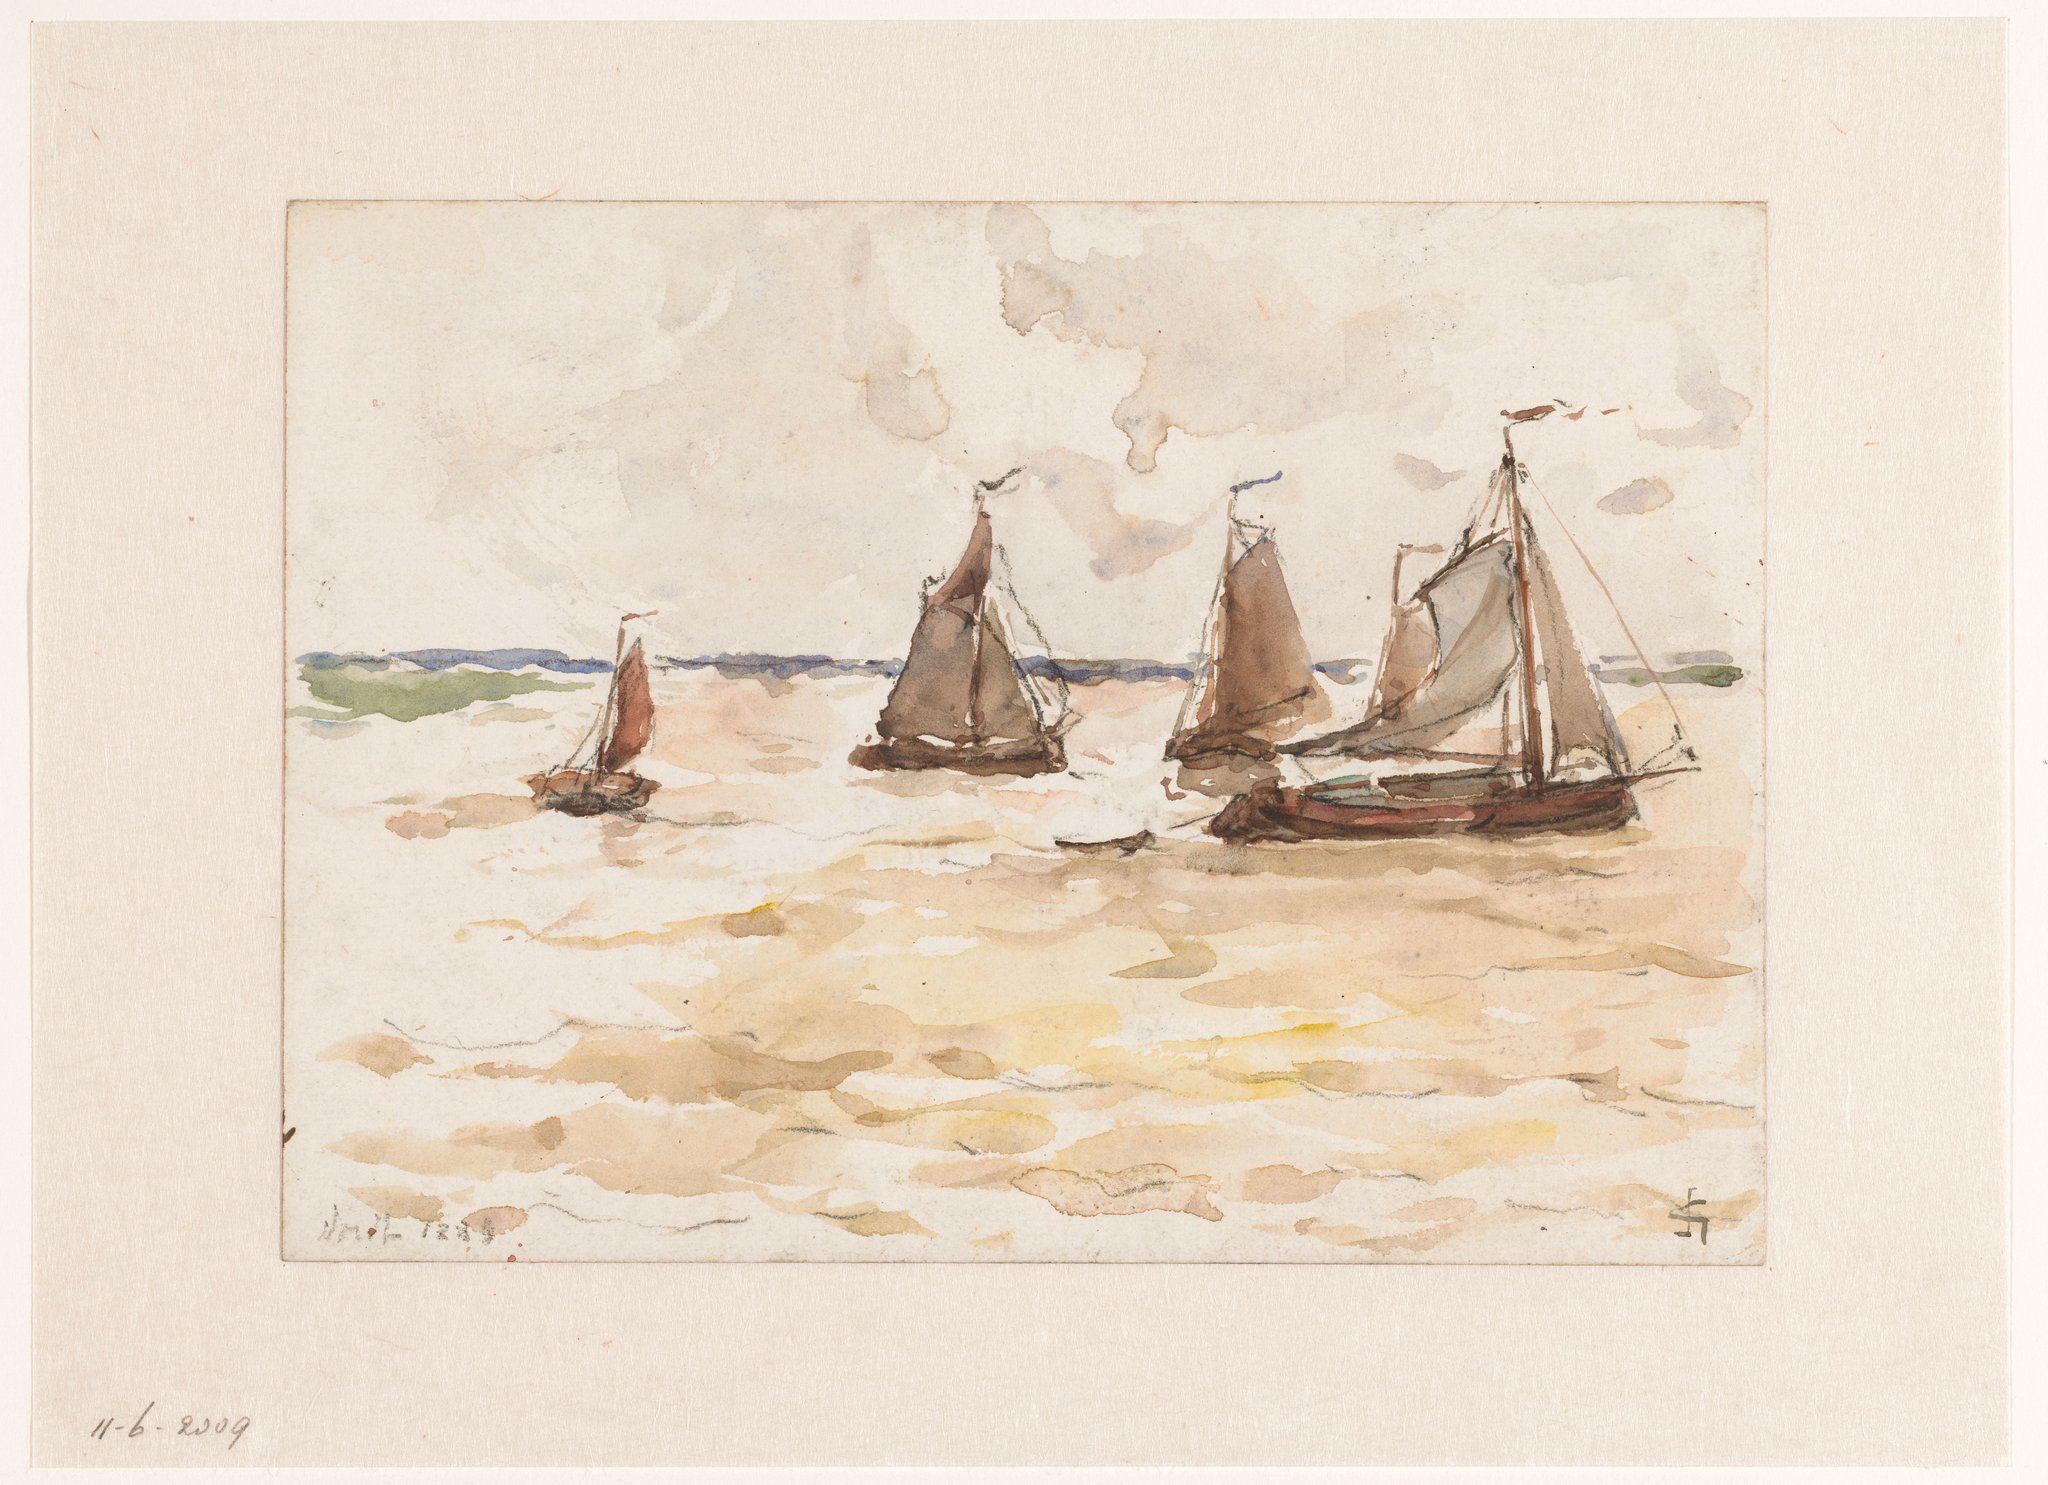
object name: drawing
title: Vissersschepen op een rivier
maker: carel nicolaas storm van s-gravesande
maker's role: draughtsman, print maker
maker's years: 1841-1924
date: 1851-1899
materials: chalk, paper, watercolor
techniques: brush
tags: commercial fishery, ships (in general) - cc - more than one ship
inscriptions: date: ‘18..’